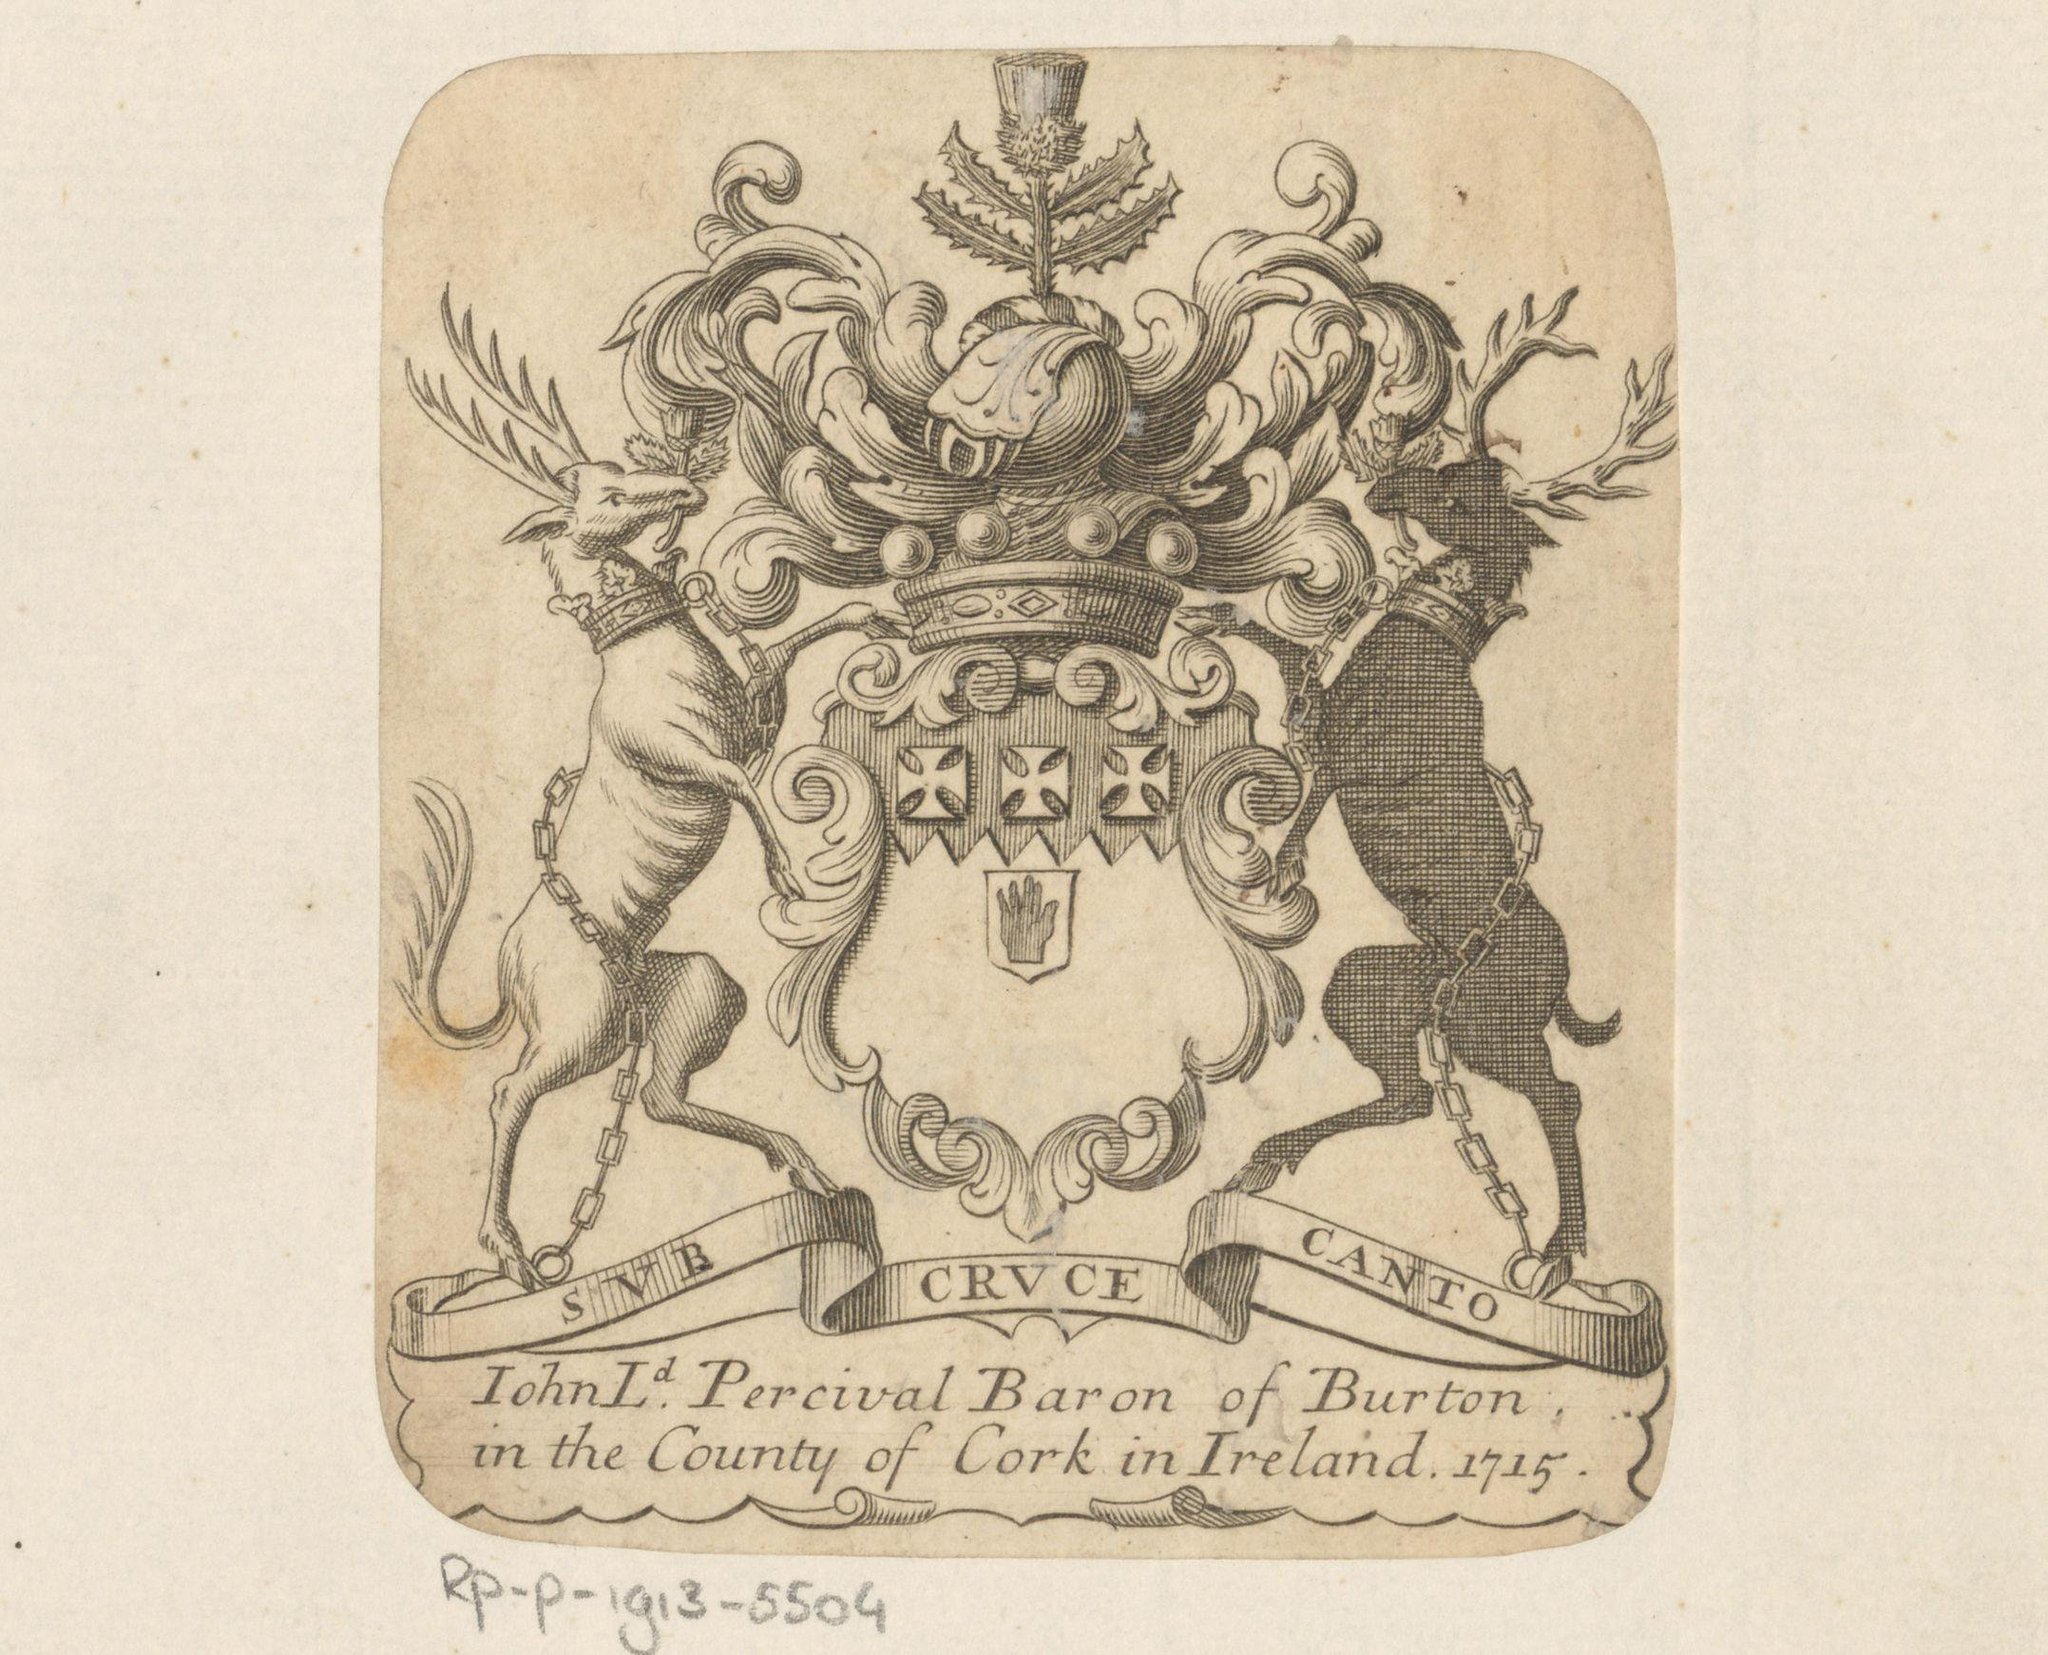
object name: bookplate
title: Sub cruce canto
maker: Anonymous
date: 1715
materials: paper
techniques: engraving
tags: politician, armorial bearing, heraldry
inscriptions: collector's mark: Lugt 2760, collector's mark: Lugt 2233